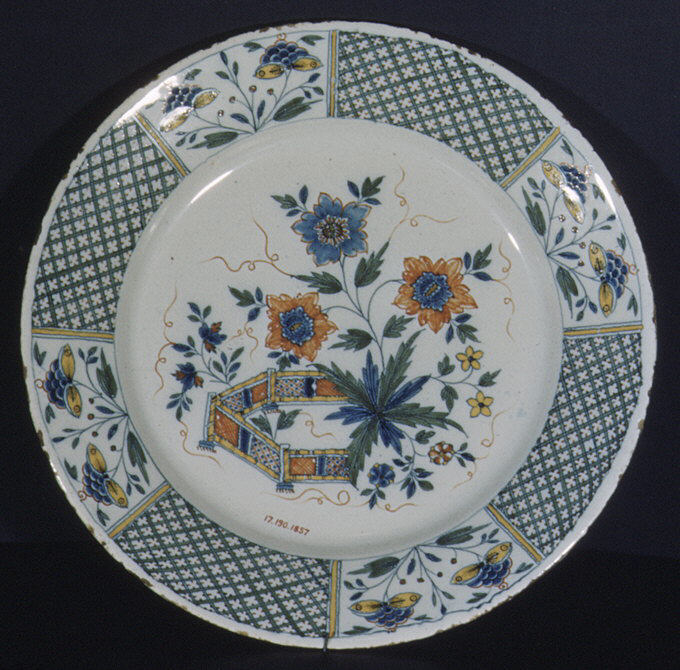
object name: plate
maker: jean-baptiste guillibaud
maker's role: factory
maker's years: 1720-1739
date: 1730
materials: faience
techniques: glazing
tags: flowers